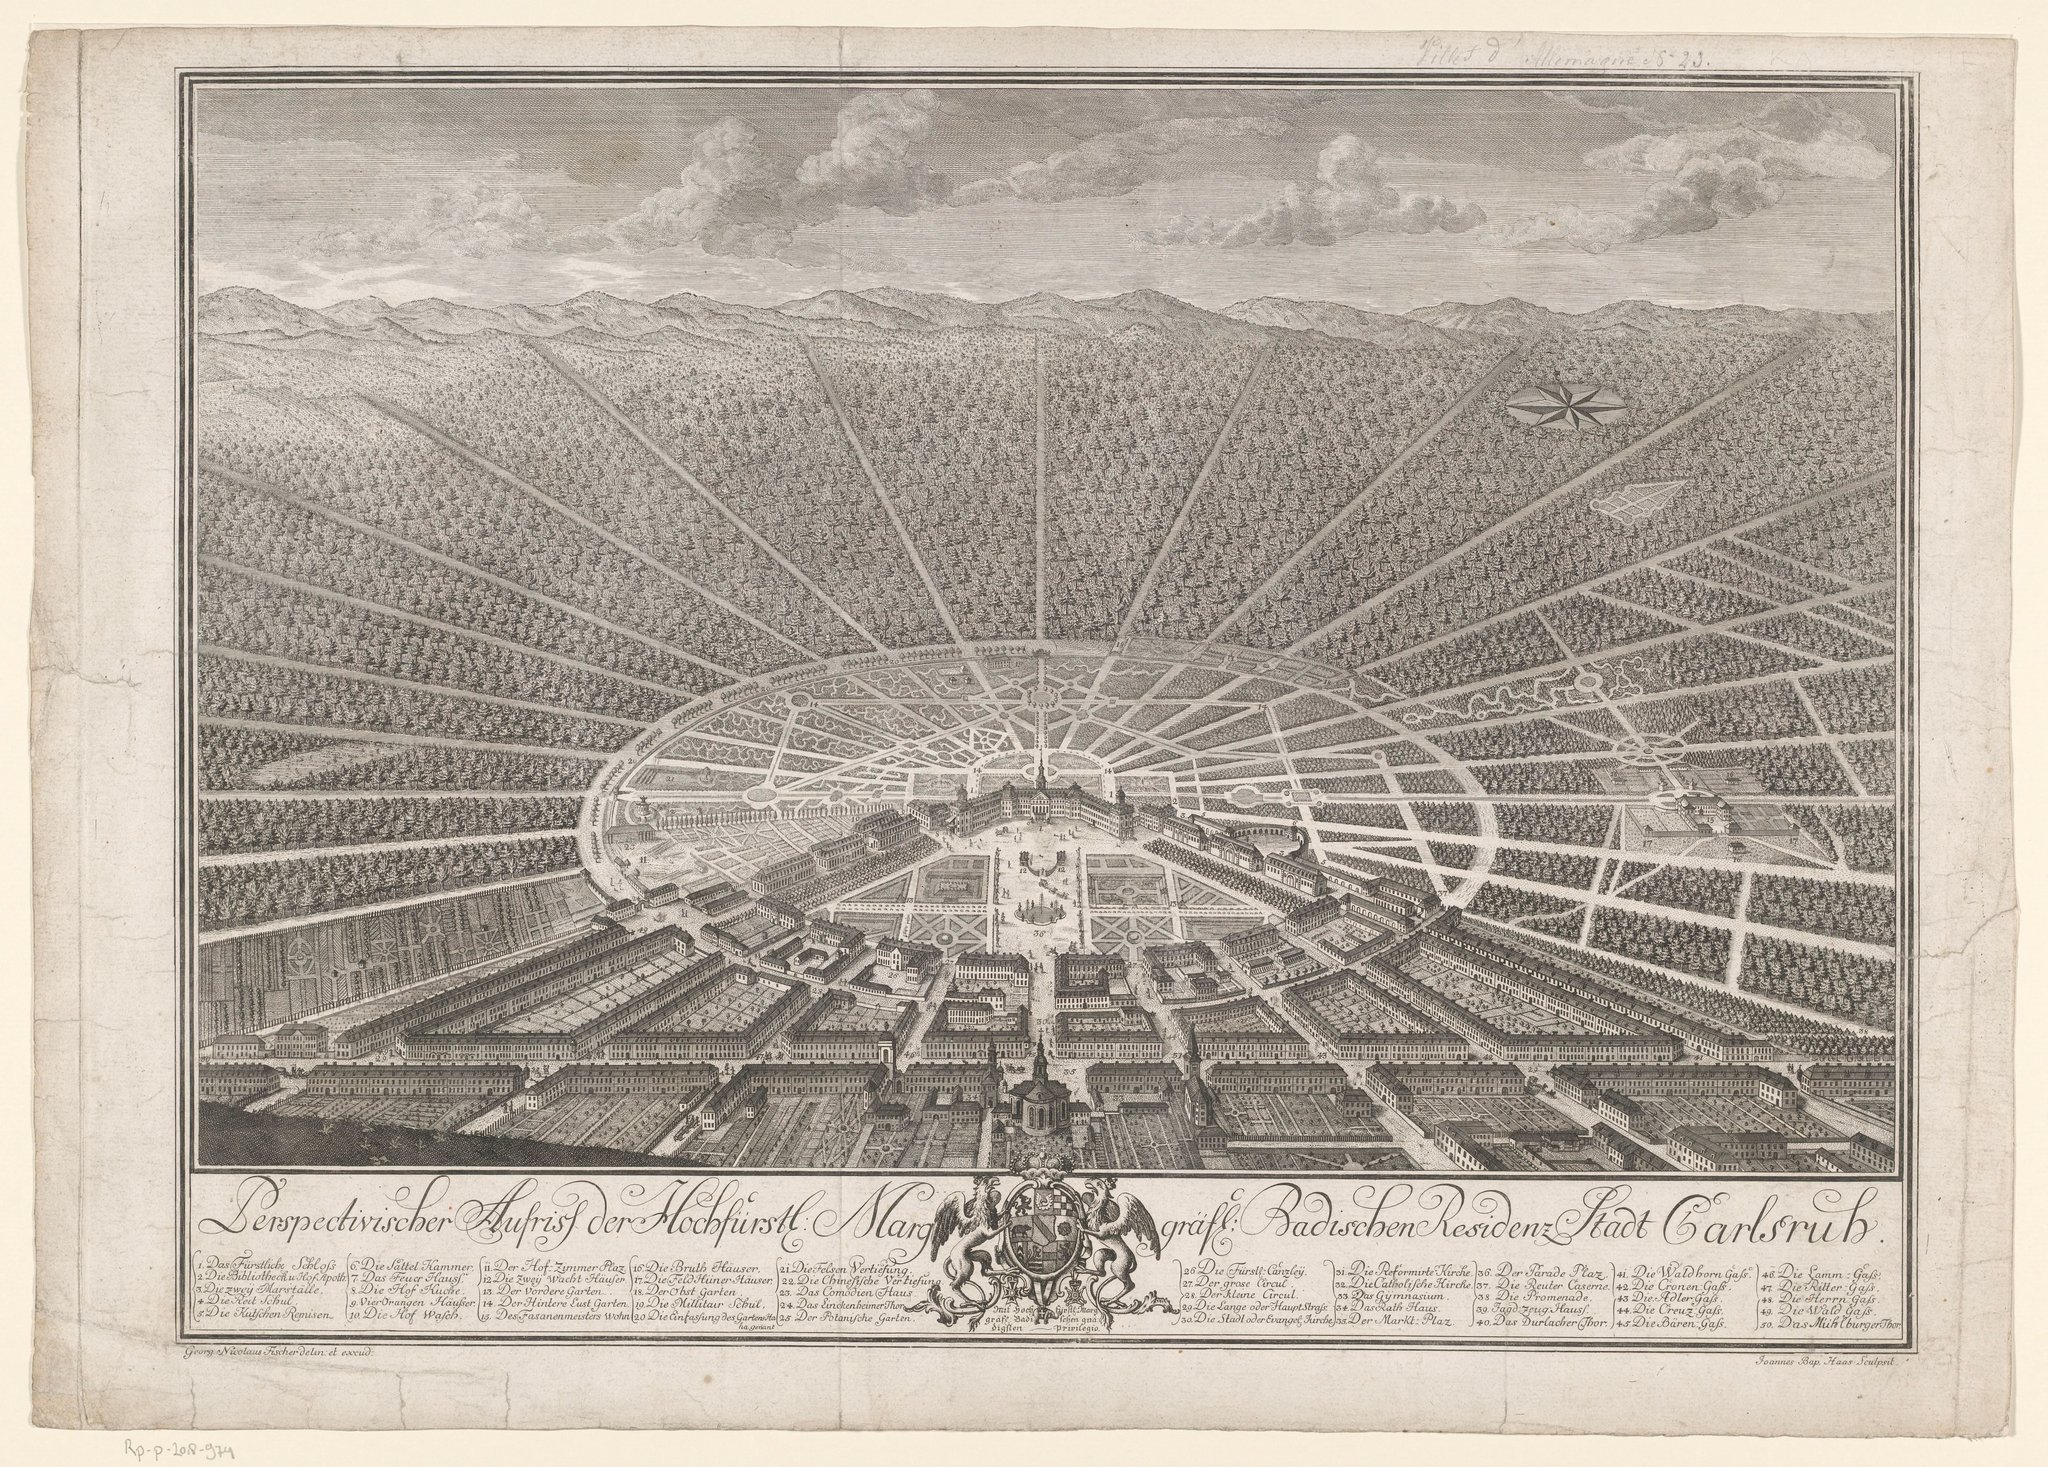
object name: print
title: Gezicht op het paleis van Karlsruhe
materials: paper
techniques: engraving, etching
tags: palace, armorial bearing, heraldry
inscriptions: collector's mark: Lugt 2228